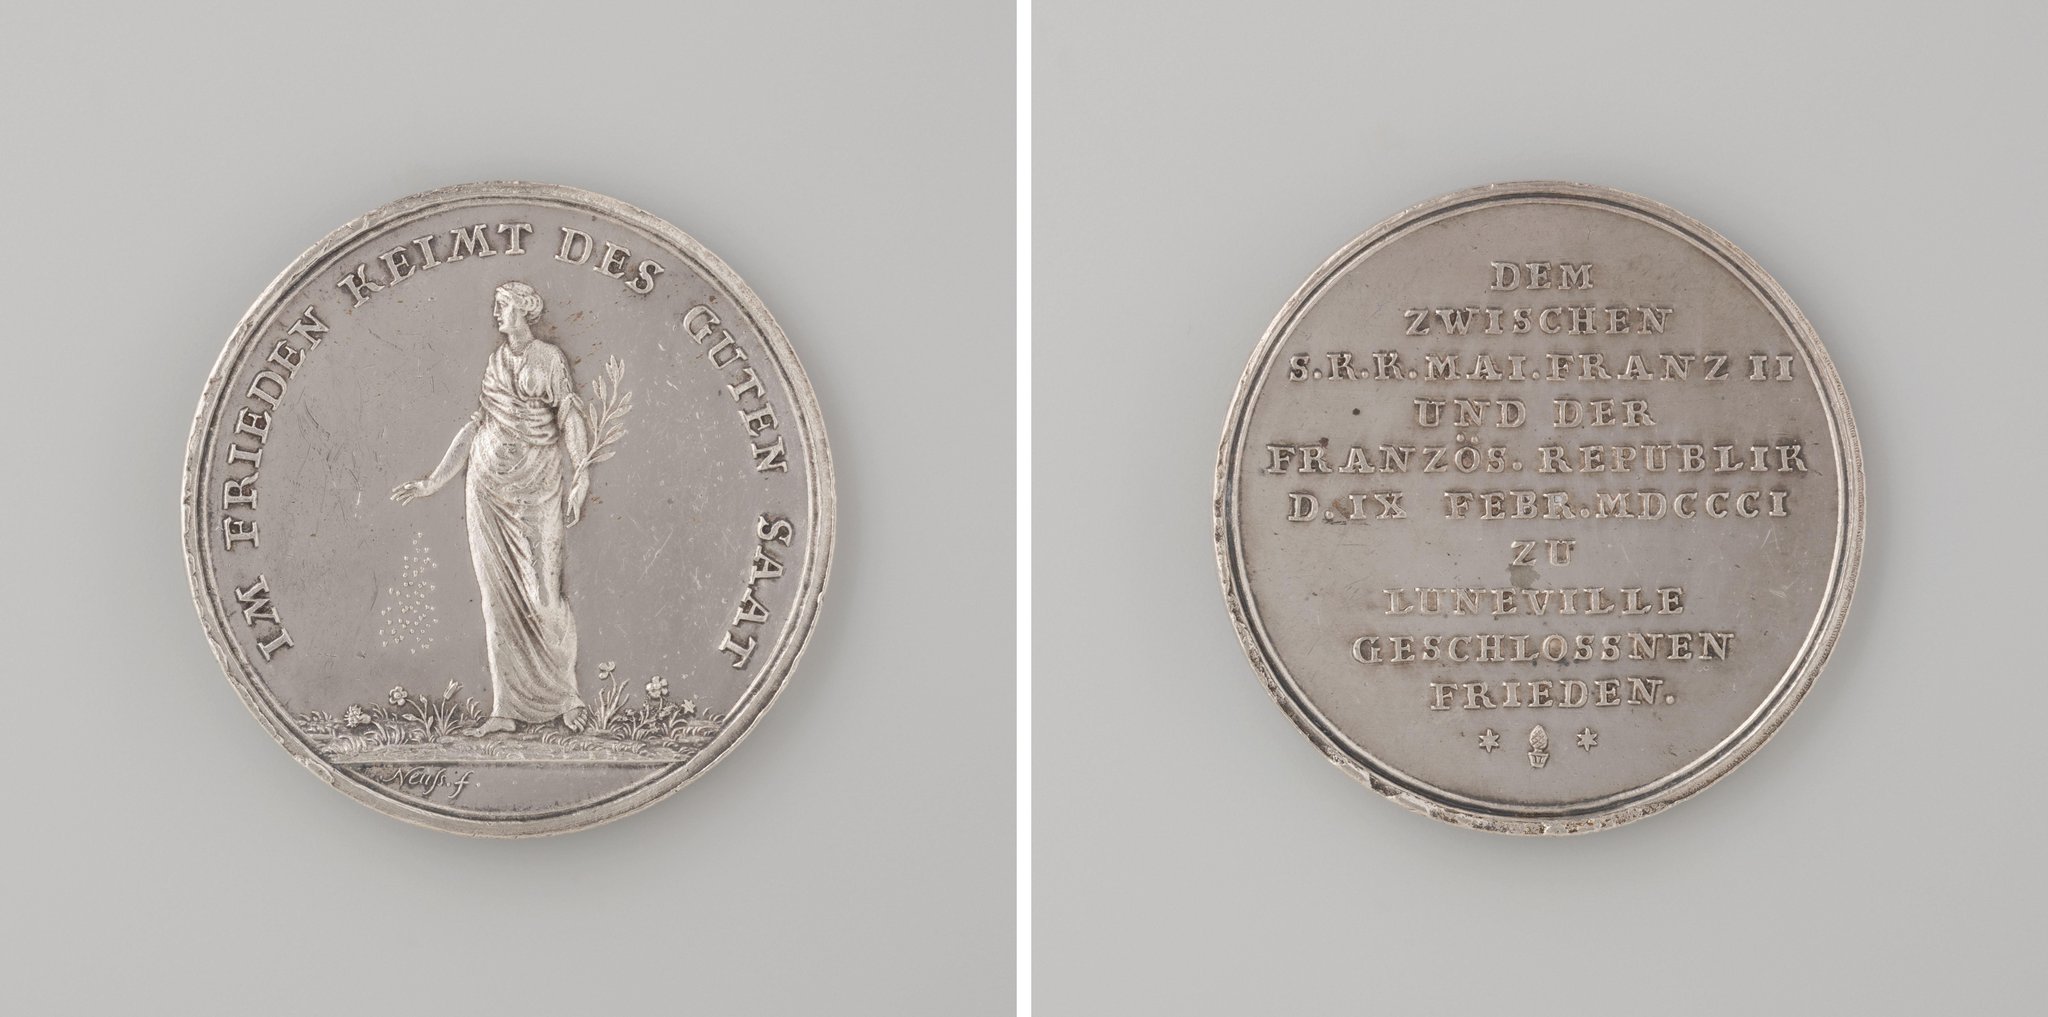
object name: history medal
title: Vrede van Luneville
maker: johann jakob neuss (der jüngere)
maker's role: medailleur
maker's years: 1770-1847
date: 1801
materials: silver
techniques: striking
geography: augsburg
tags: vienna, frans ii (rooms-duits keizer), napoleon i (emperor of the french)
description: Zilveren penning. Voorzijde: Vrede, afgebeeld als vrouw met olijftak in hand, strooit zaad uit over veld met bloemen binnen omschrift; afsnede: signatuur. Keerzijde: opschrift